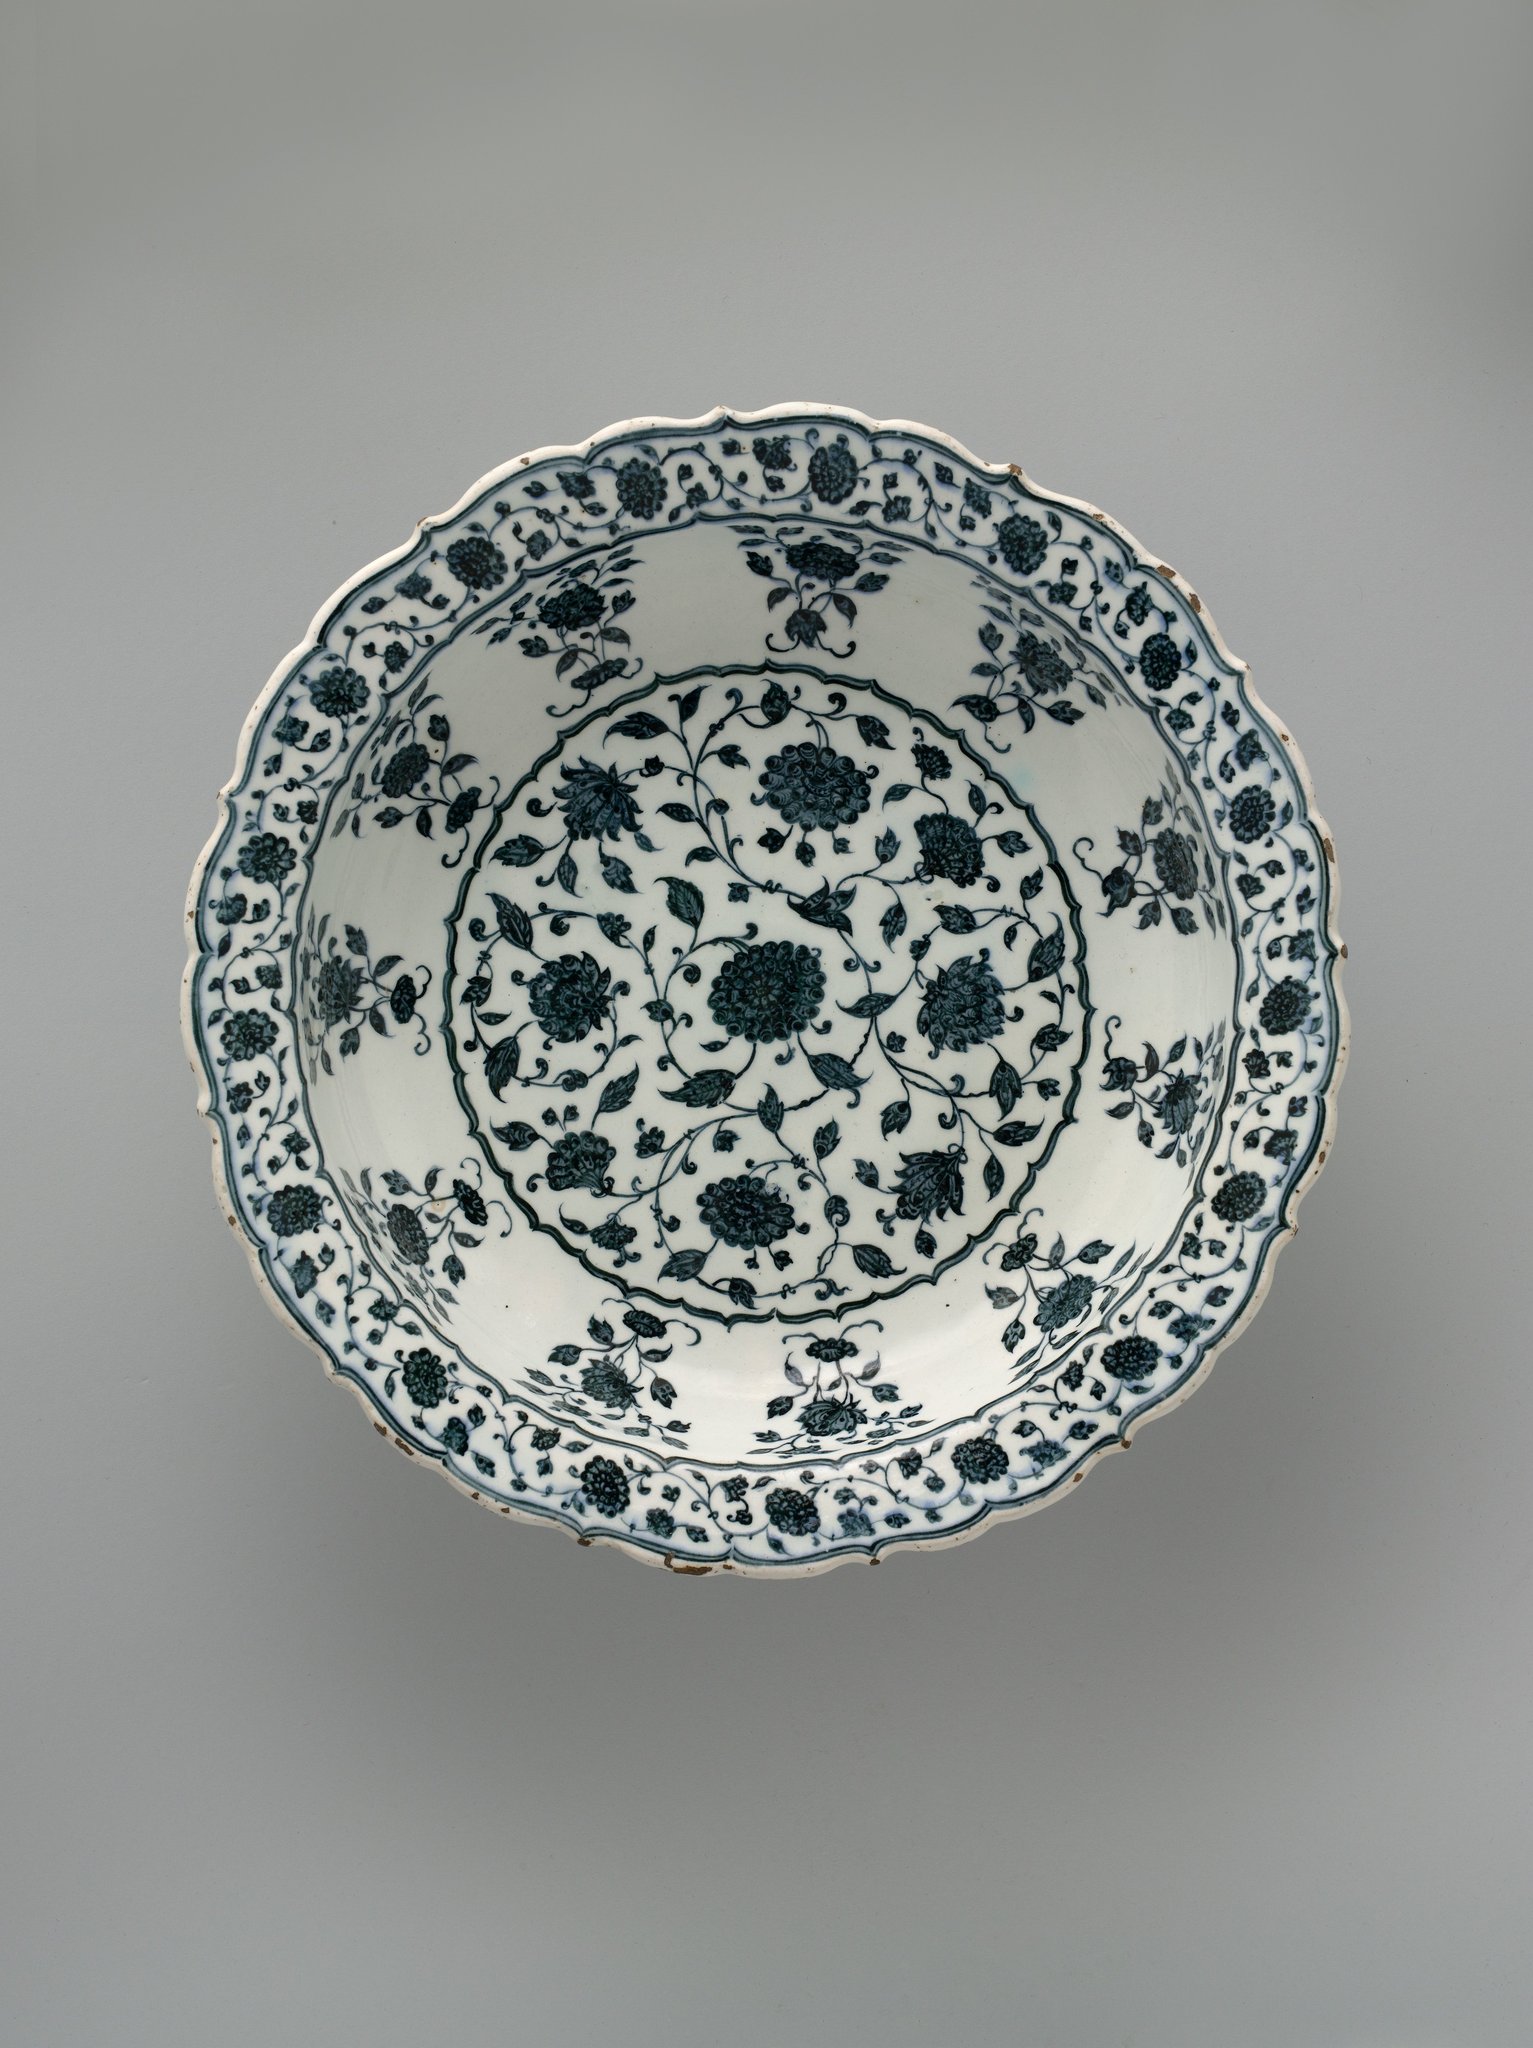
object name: dish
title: Footed Dish with Foliate Rim in Imitation of Chinese Porcelain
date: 1570-1580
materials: glaze, stonepaste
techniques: painting, polychrome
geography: turkey